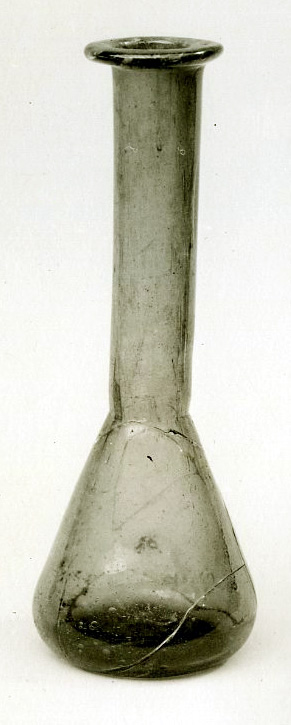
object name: bottle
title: Glass Bottle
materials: glass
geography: egypt